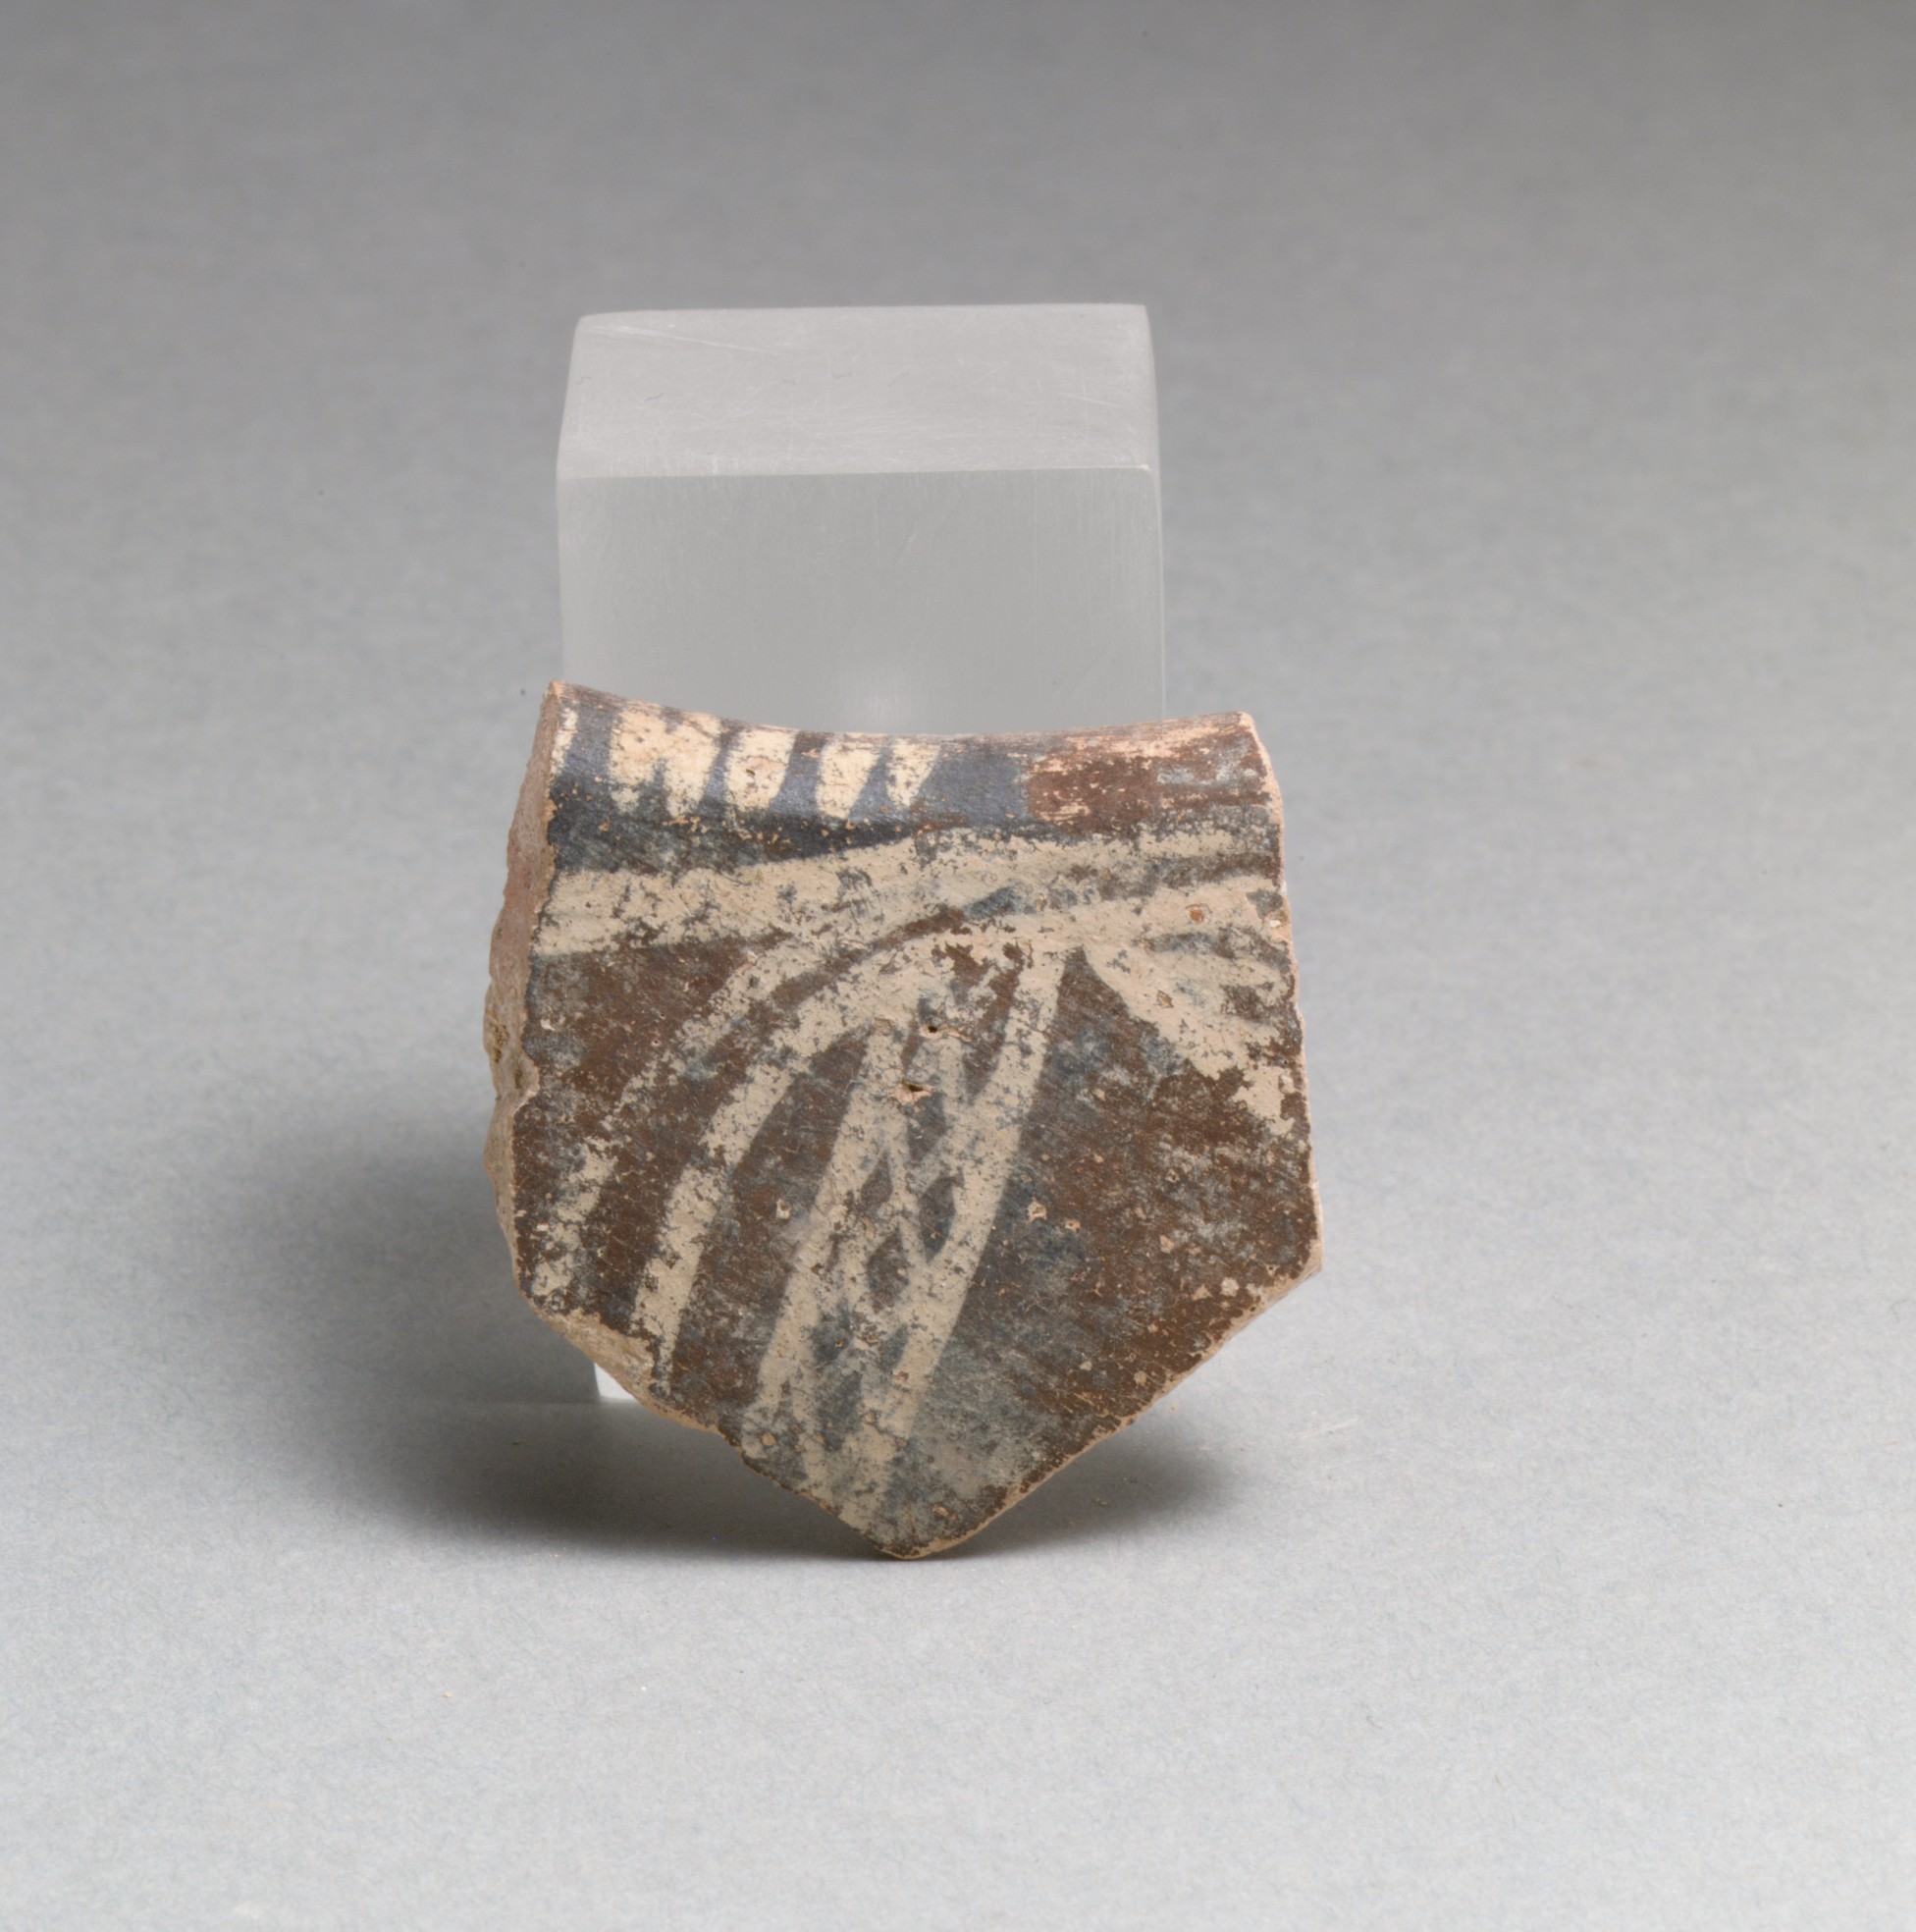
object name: vase fragment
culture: minoan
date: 2600-2000 BCE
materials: terracotta